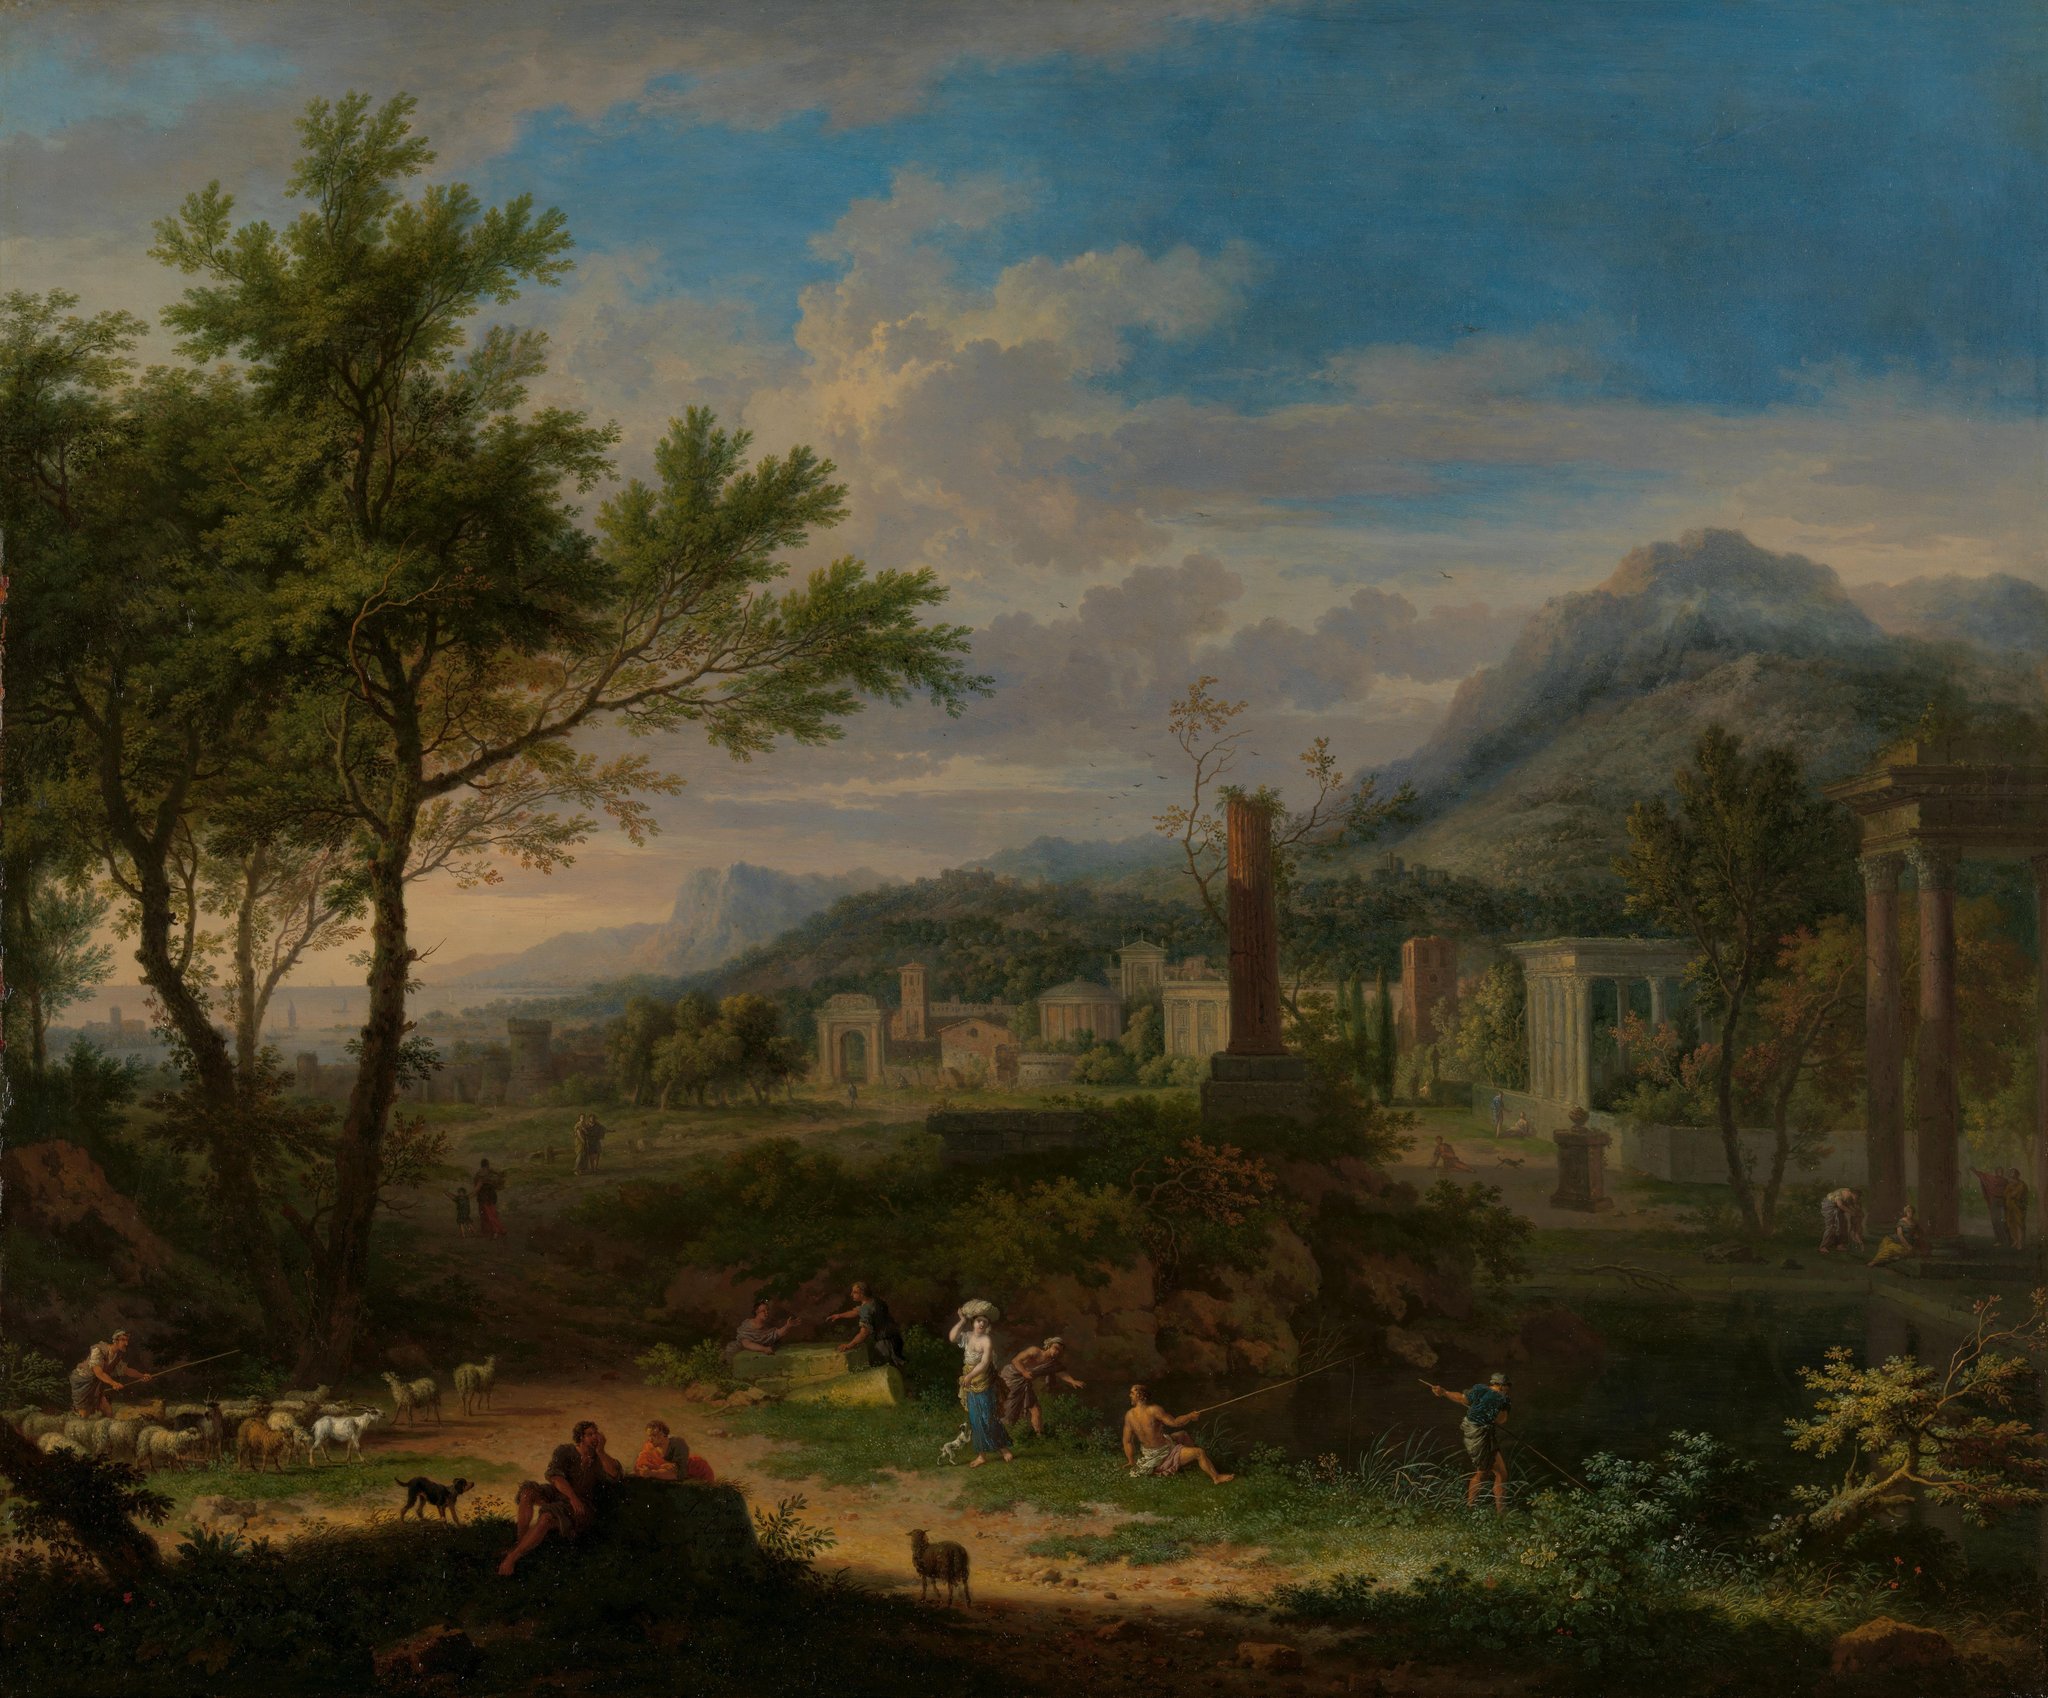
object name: painting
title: Arcadian Landscape with Fishermen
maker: jan van huysum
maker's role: draughtsman, painter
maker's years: 1682-1749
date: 1700-1749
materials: copper, oil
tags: landscape with ruins - ii - ideal landscapes, angling, pastorals, arcadian scenes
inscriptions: signature: ‘Jan Van Huysum fecit’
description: These two scenes are painted on copper, a support that allowed Van Huysum to achieve a remarkably smooth and shiny result. Depicted are Arcadian, or idyllic, landscapes, with temples and figures from Classical antiquity. They are small gems intended for an art lover’s collection.